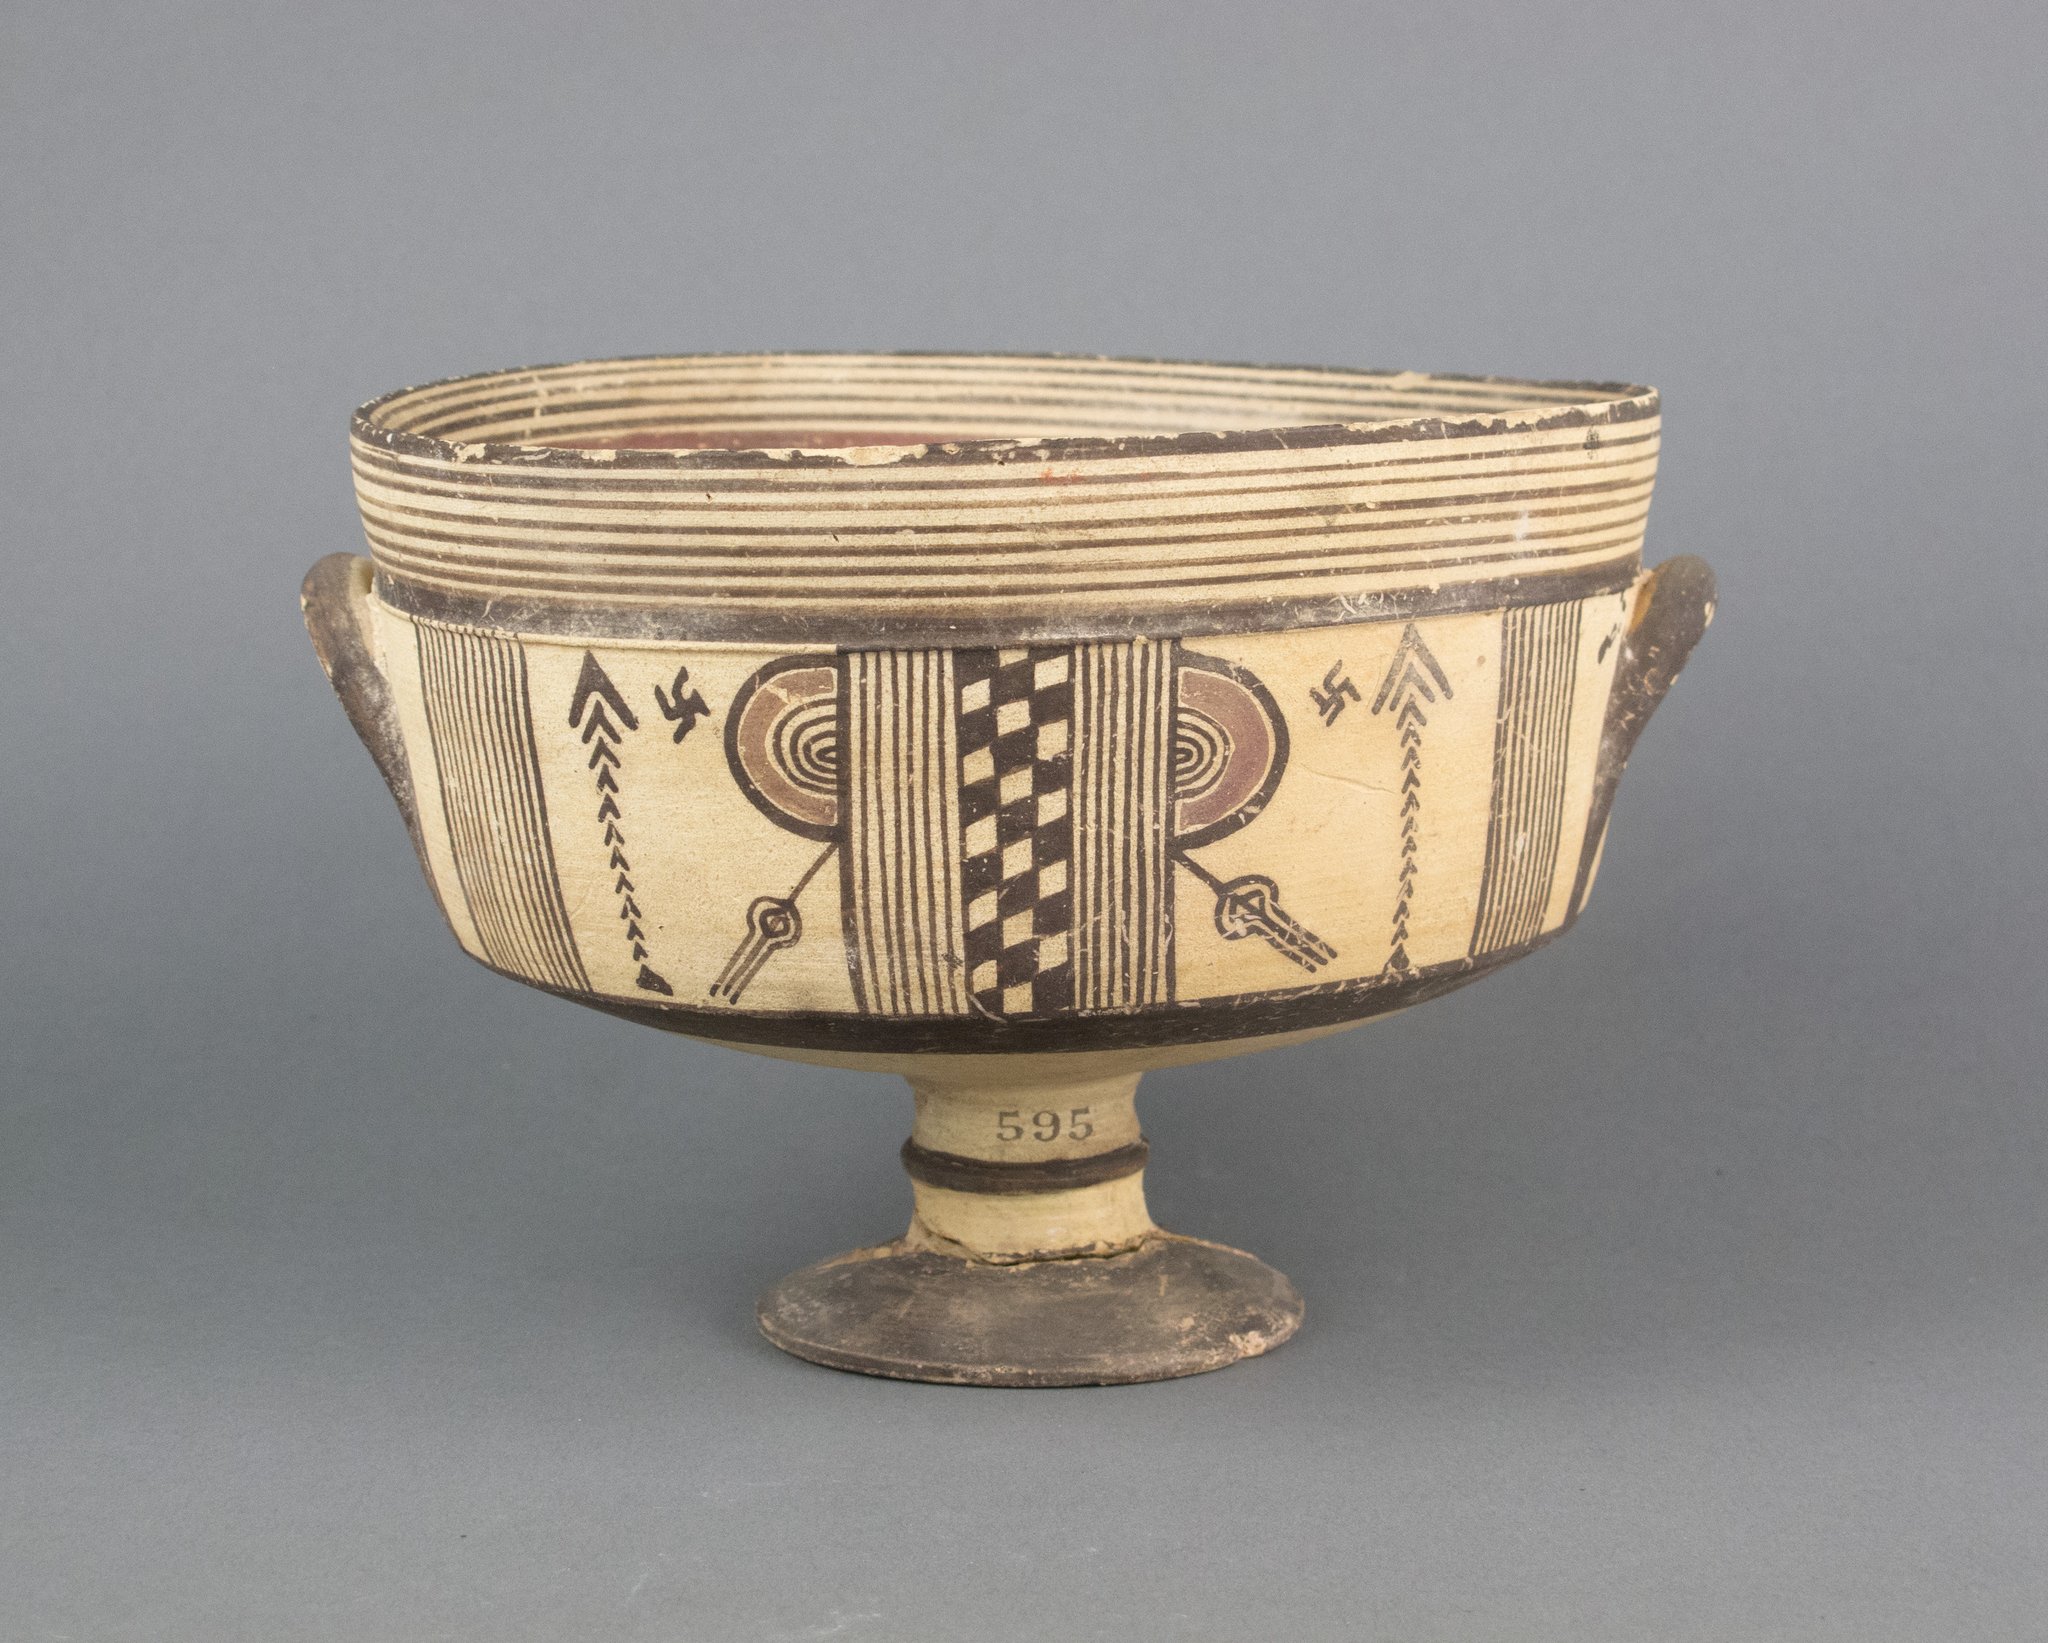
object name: kylix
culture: cypriot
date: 850-750 BCE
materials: terracotta